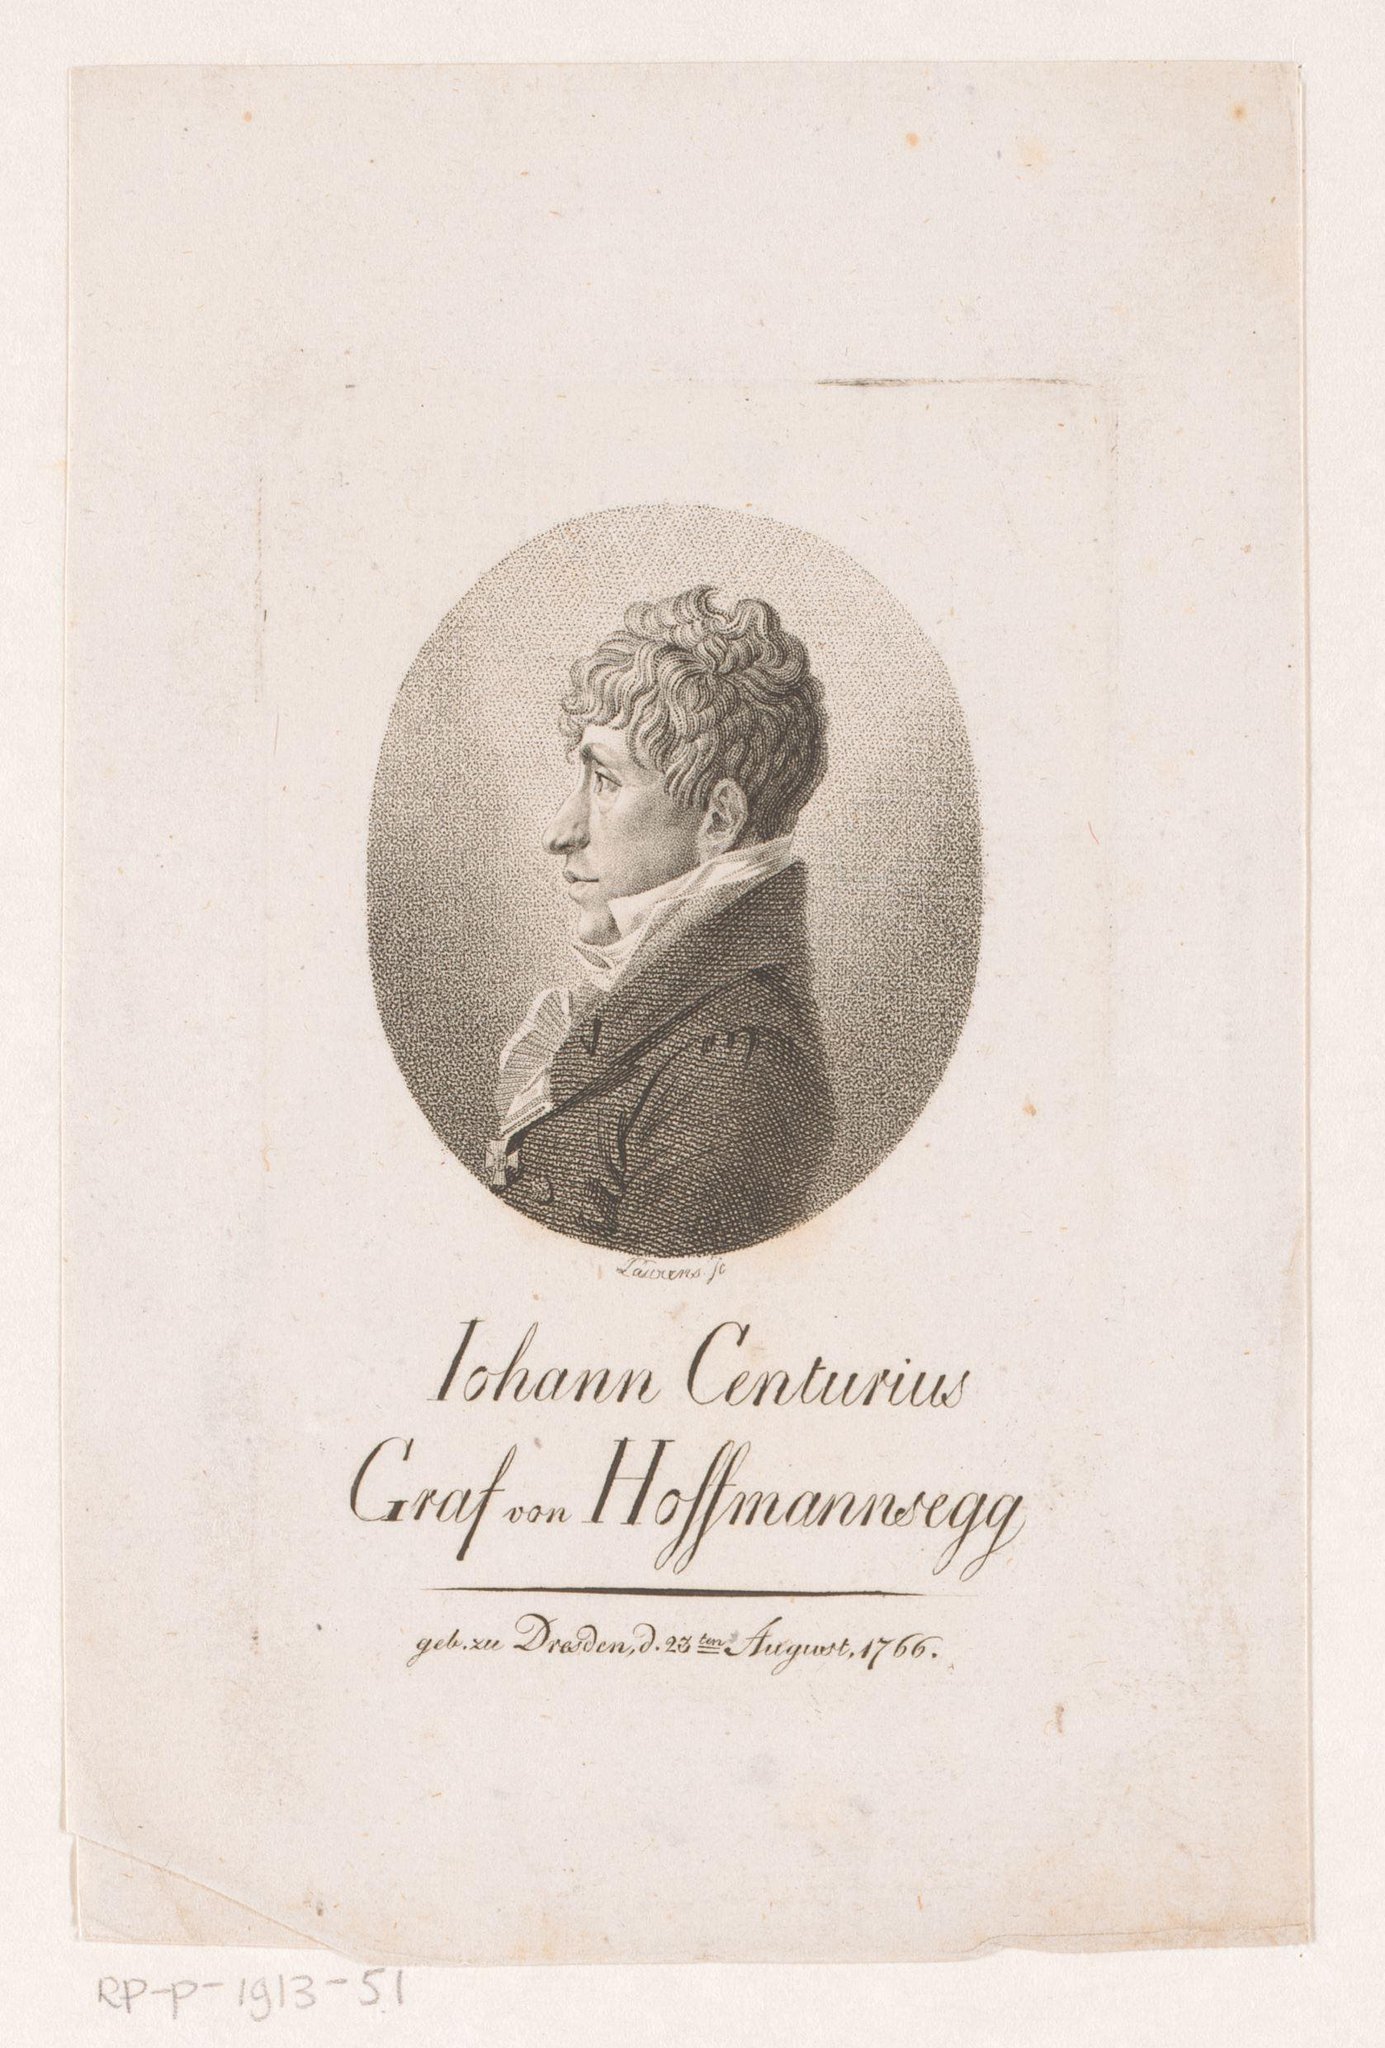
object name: print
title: Portret van Johann Centurius von Hoffmannsegg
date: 1811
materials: paper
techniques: stippling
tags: botany (+ portrait of scholar, scientist), historical persons, scholar, philosopher (+ portrait of scholar, scientist)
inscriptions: collector's mark: Lugt 2228